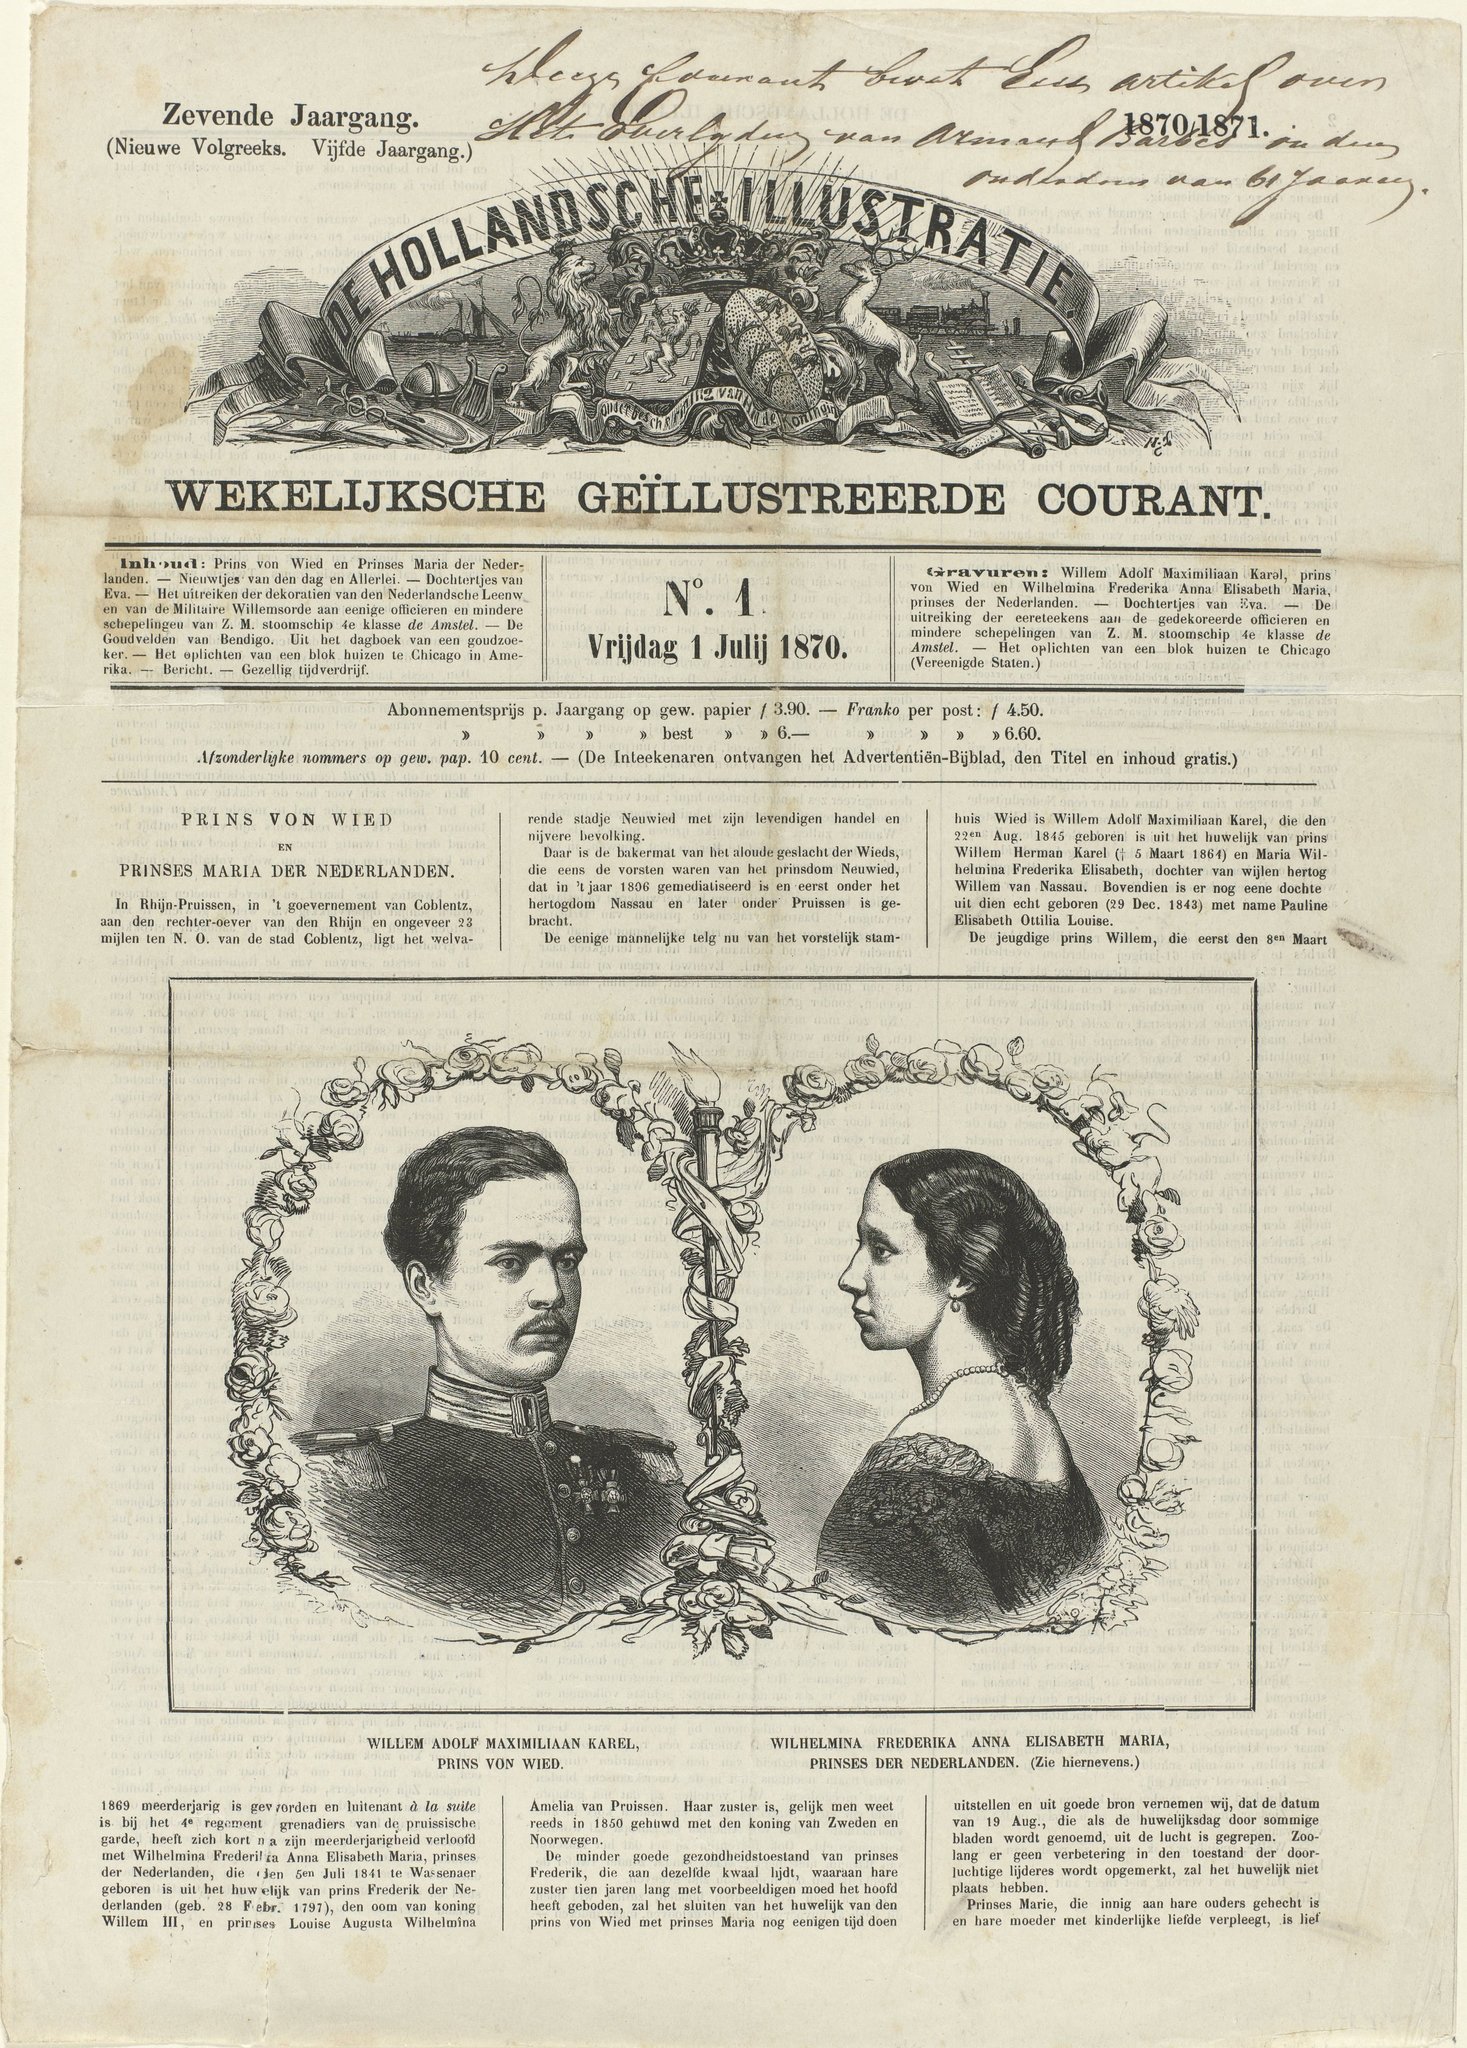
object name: newspaper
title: Krant met een artikel over de verloving van Willem Adolf van Wied en Marie, prinses der Nederlanden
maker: Anonymous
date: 1870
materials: paper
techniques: letterpress printing, engraving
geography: netherlands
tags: willem adolf vorst van wied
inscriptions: date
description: Krant met een artikel over de verloving van Willem Adolf en Marie. In het midden potretten van Willem Adolf en Marie, elk in een ovaal van bloemen. Daar omheen kolommen en kaders met Nederlandse tekst in boekdruk. Midden boven twee wapens met een kroon, een leeuw en een hert. Daar omheen een aantal allegorische objecten en twee banderollen met elk een regel Nederlandse tekst.